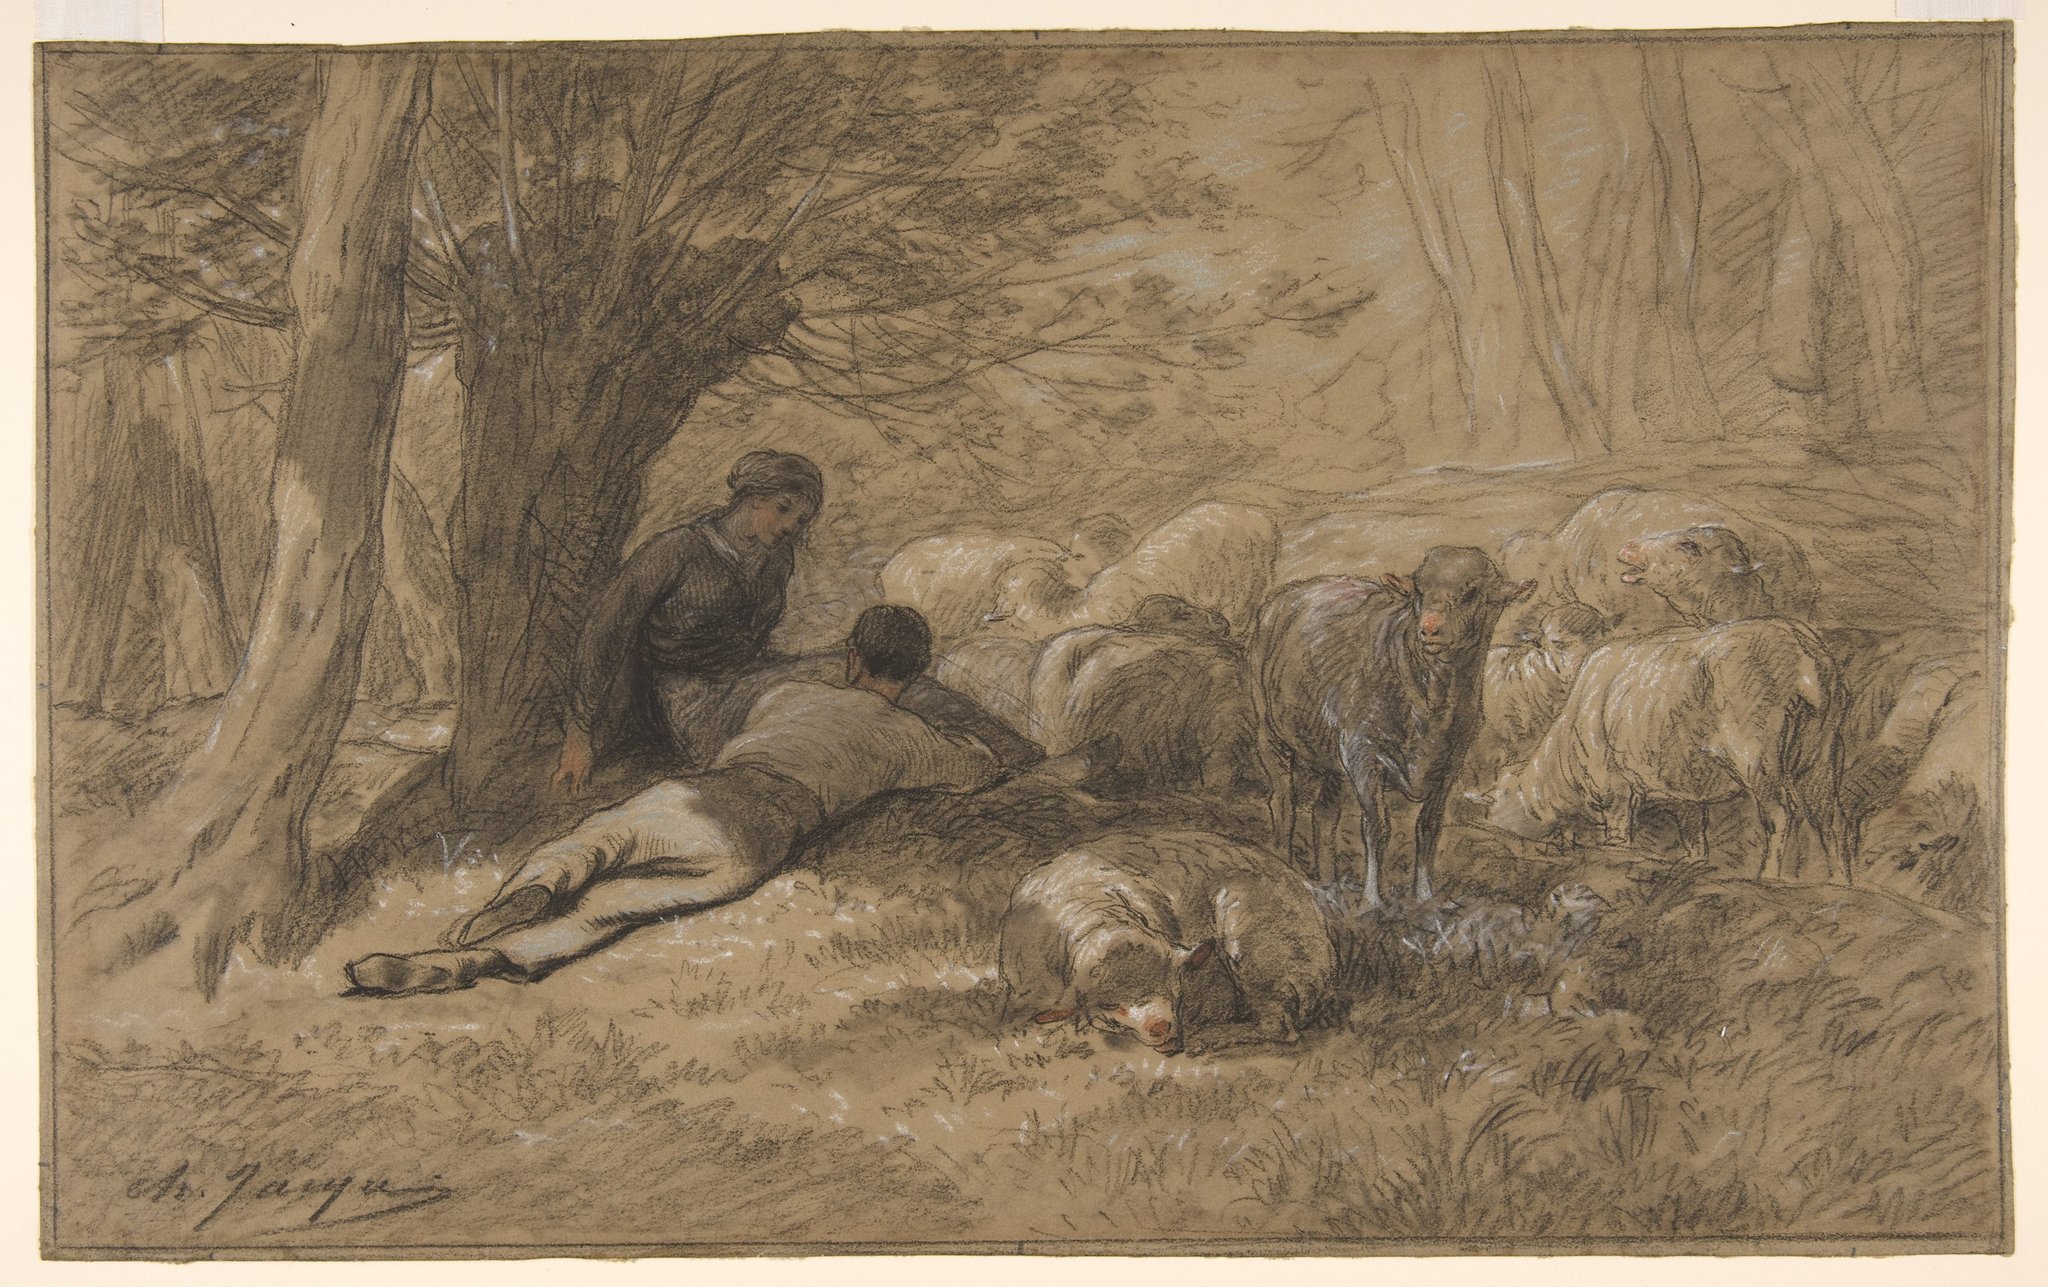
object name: drawing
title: Tending the Sheep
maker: charles émile jacque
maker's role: artist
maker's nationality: french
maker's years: 1813-1894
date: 1830-1894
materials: chalk, paper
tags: men,women,sheep,trees